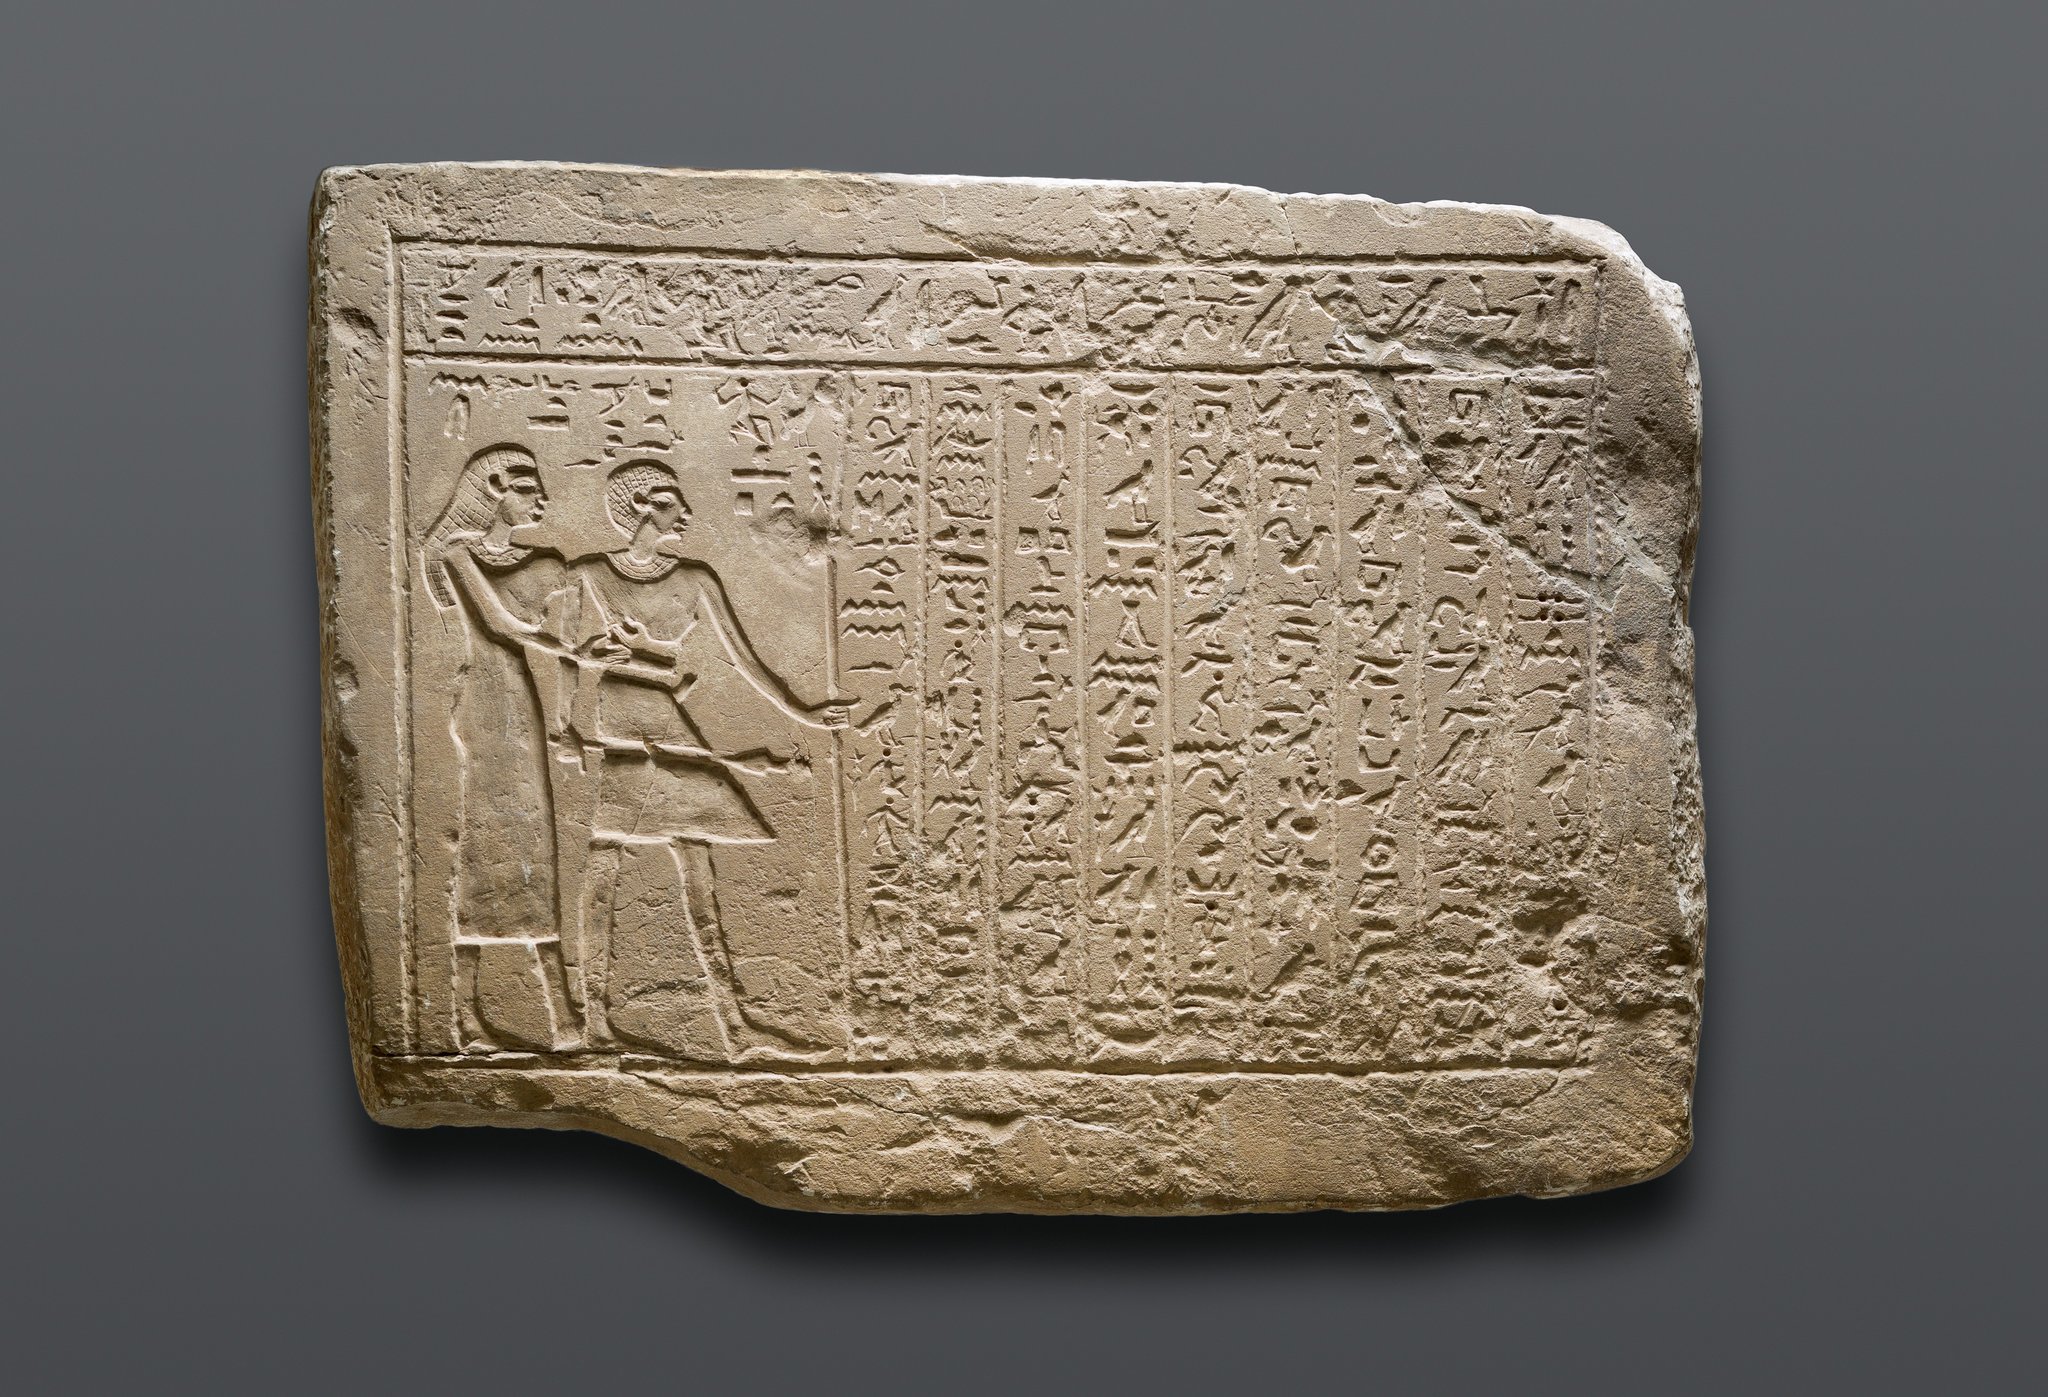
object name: stela, djemi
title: Stela of Djemi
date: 2120-2030 BCE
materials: limestone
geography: southern upper egypt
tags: men,women,hieroglyphs